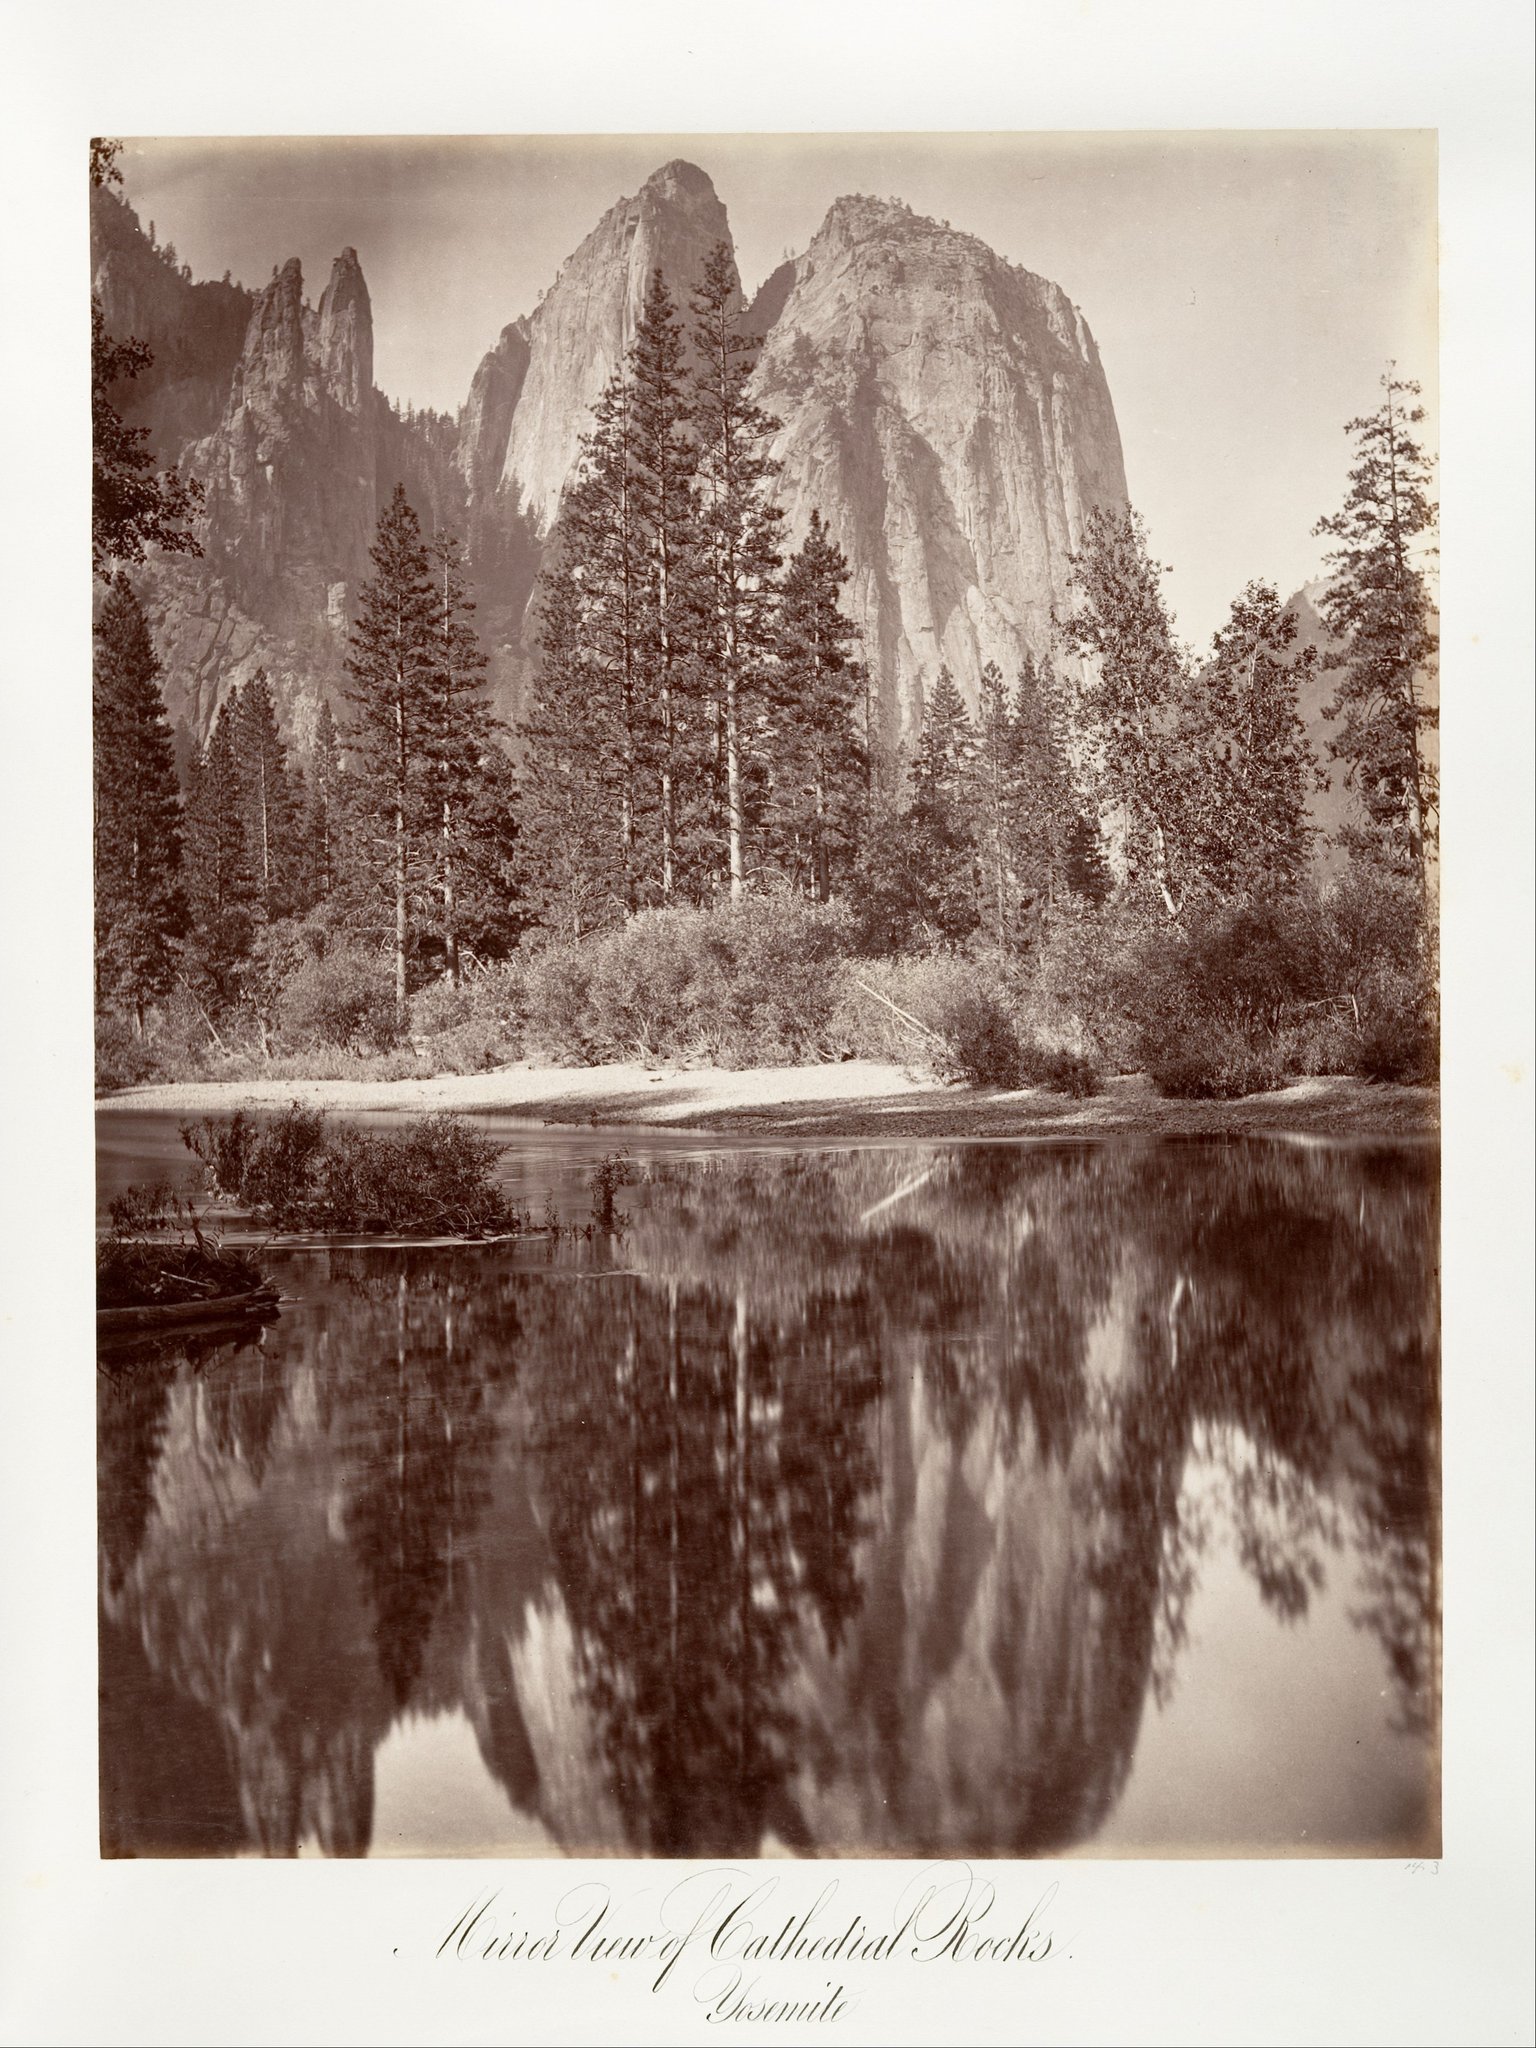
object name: photograph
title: Mirror View of Cathedral Rocks, Yosemite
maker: carleton e. watkins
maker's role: artist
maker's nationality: american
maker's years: 1829-1916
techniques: albumen silver print, glass negative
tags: mountains,landscapes